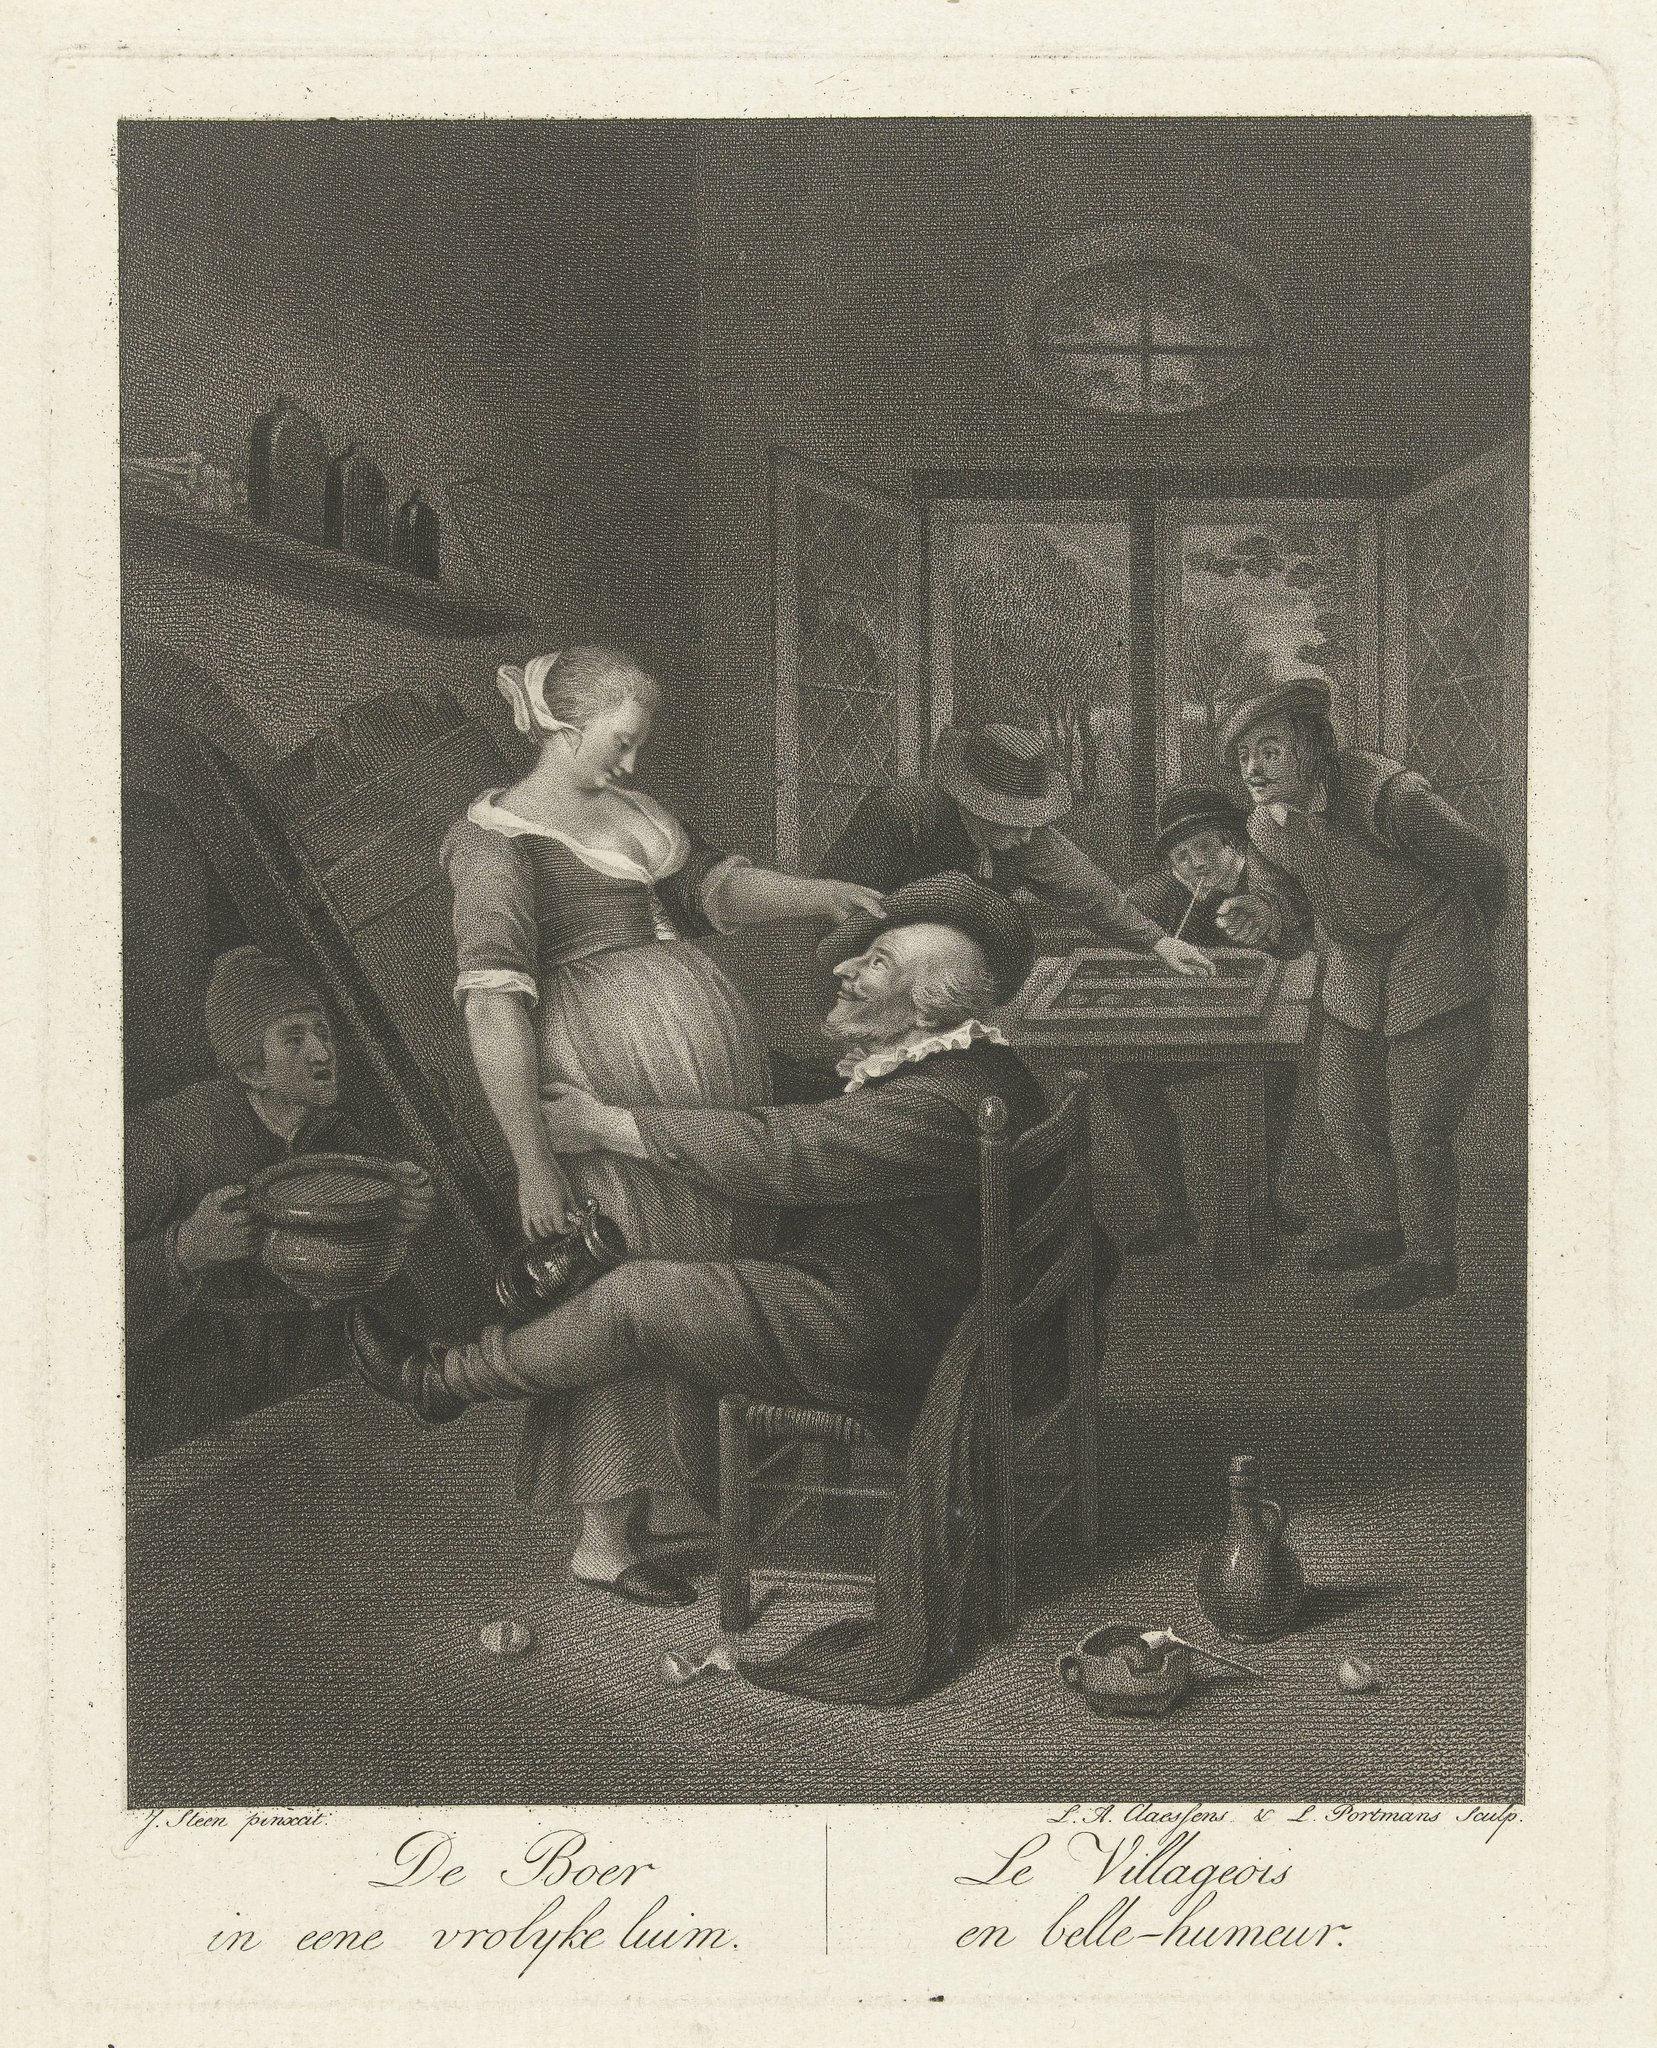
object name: print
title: Kroegscène met een oude man en een jonge vrouw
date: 1792-1834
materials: paper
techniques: etching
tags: inn, coffee-house, public house, etc., backgammon, tric-trac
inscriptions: collector's mark: Lugt 2228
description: Een oude man zit op een stoel en trekt een jonge vrouw naar zich toe. Links komt een man met een juk melk uit de kelder. Bij het raam spelen drie mannen triktrak.